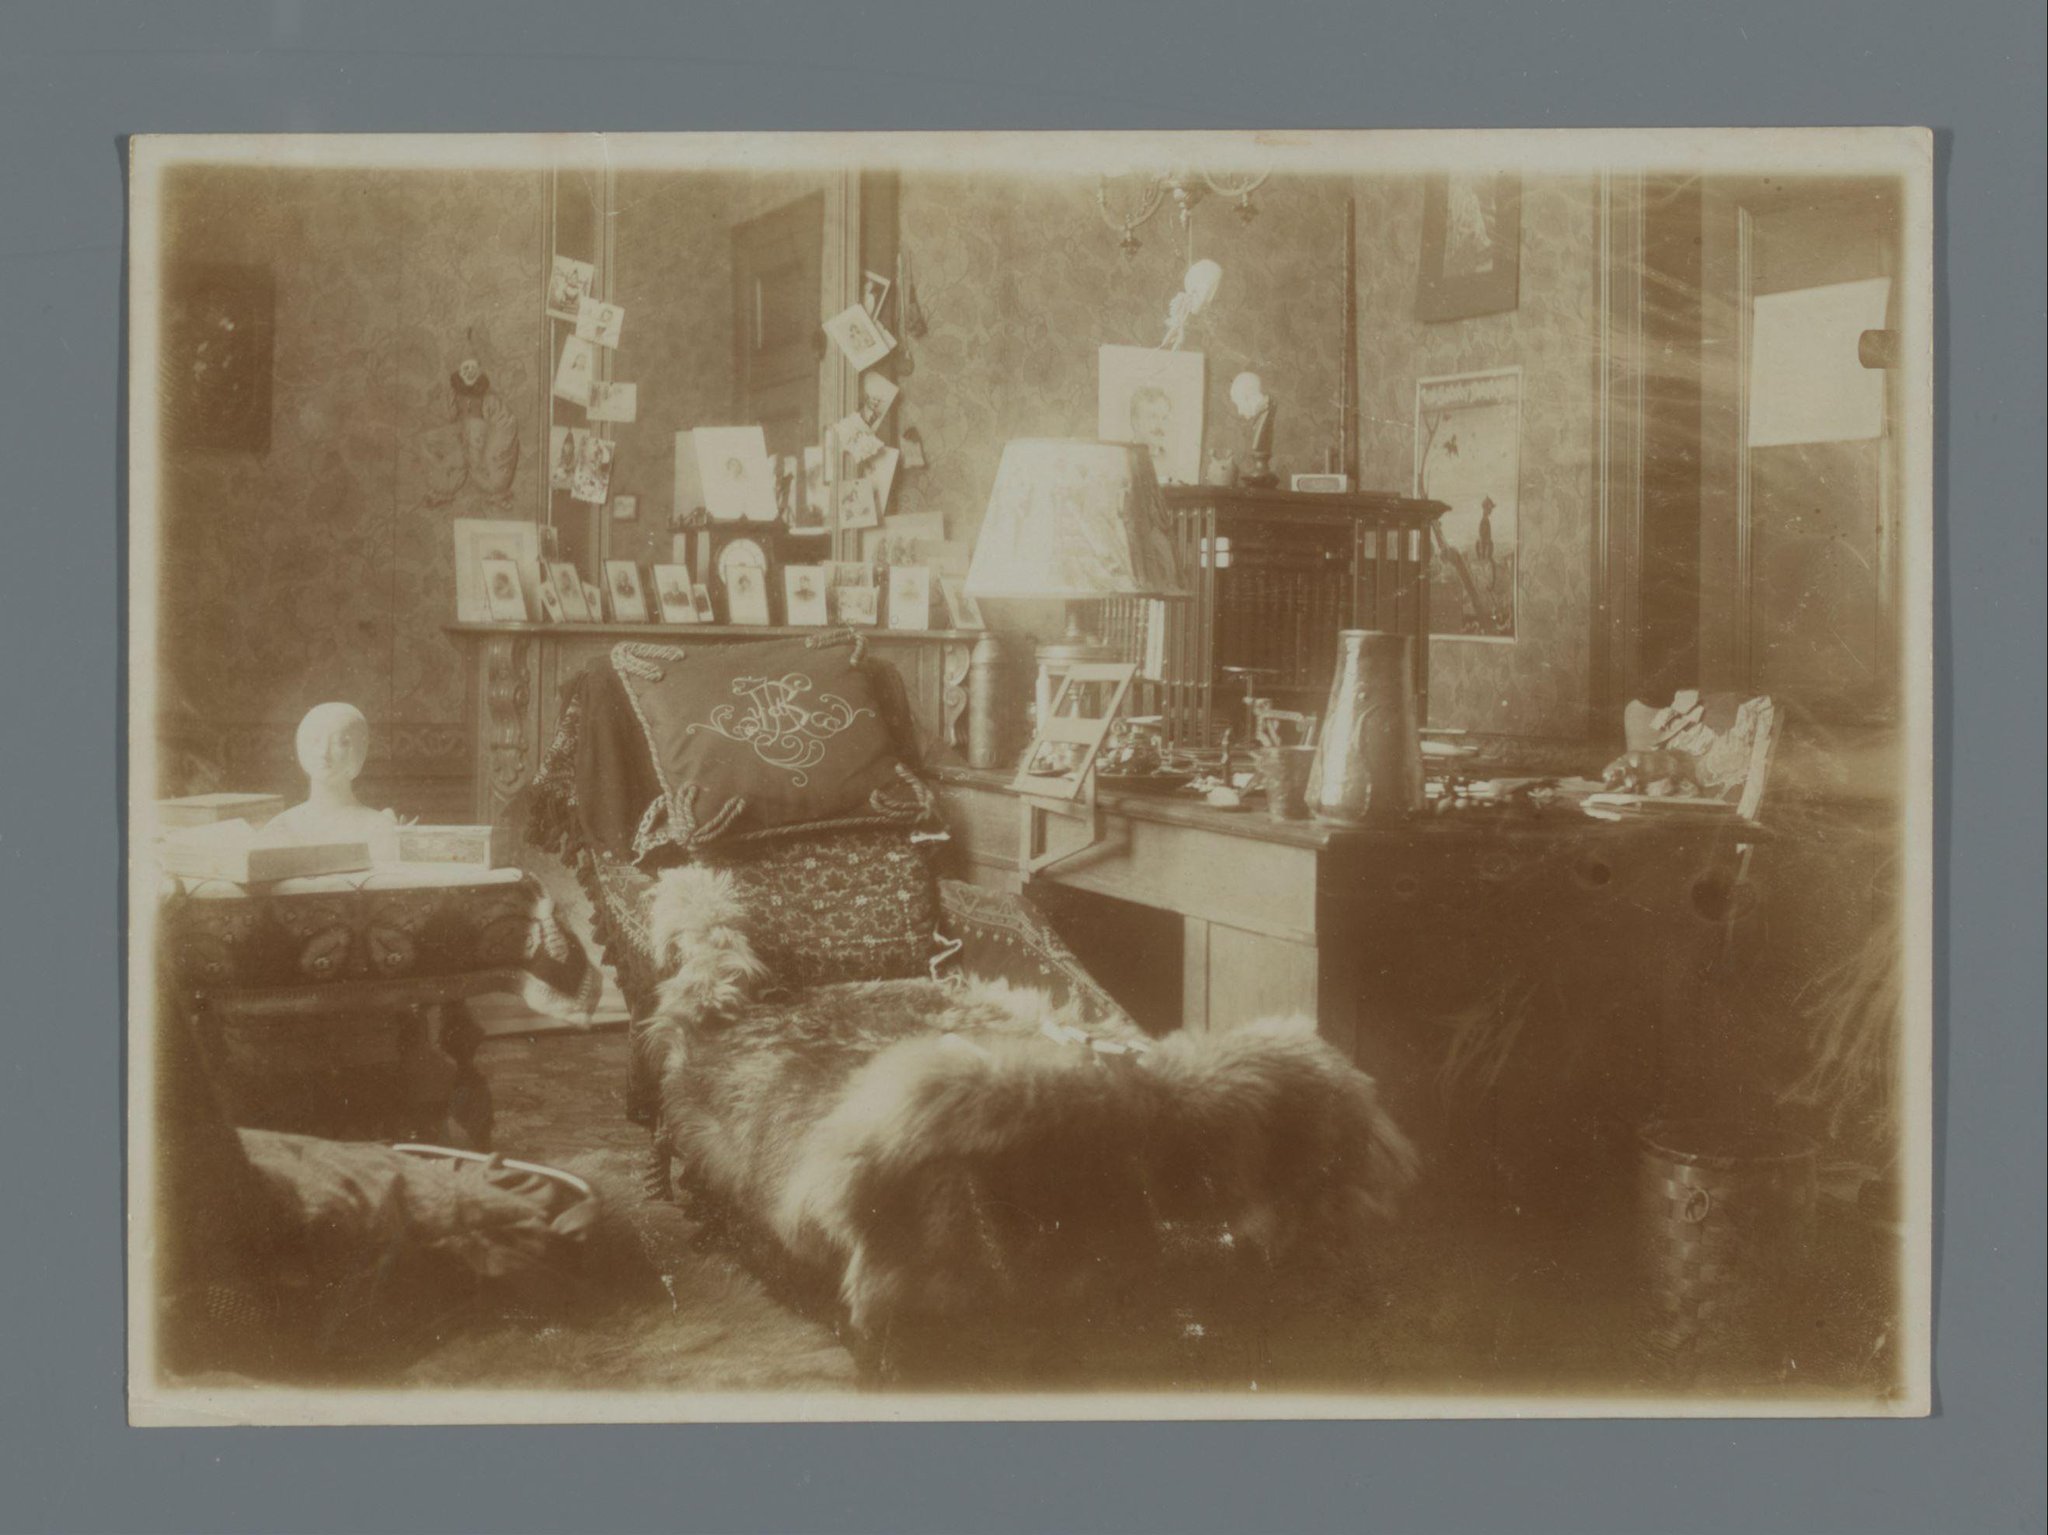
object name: photograph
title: De kamer van Henk van de Berg op de Turfmarkt 3 in Amsterdam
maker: hendrik herman van den berg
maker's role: amateurfotograaf, jurist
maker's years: 1875-1944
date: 1896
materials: photographic support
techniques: gelatin silver print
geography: amsterdam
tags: rotterdam, norbertus petrus van den berg (1831-1917), interior of the house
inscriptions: annotation: ‘Vaders kamer oude Turfmarkt 3’